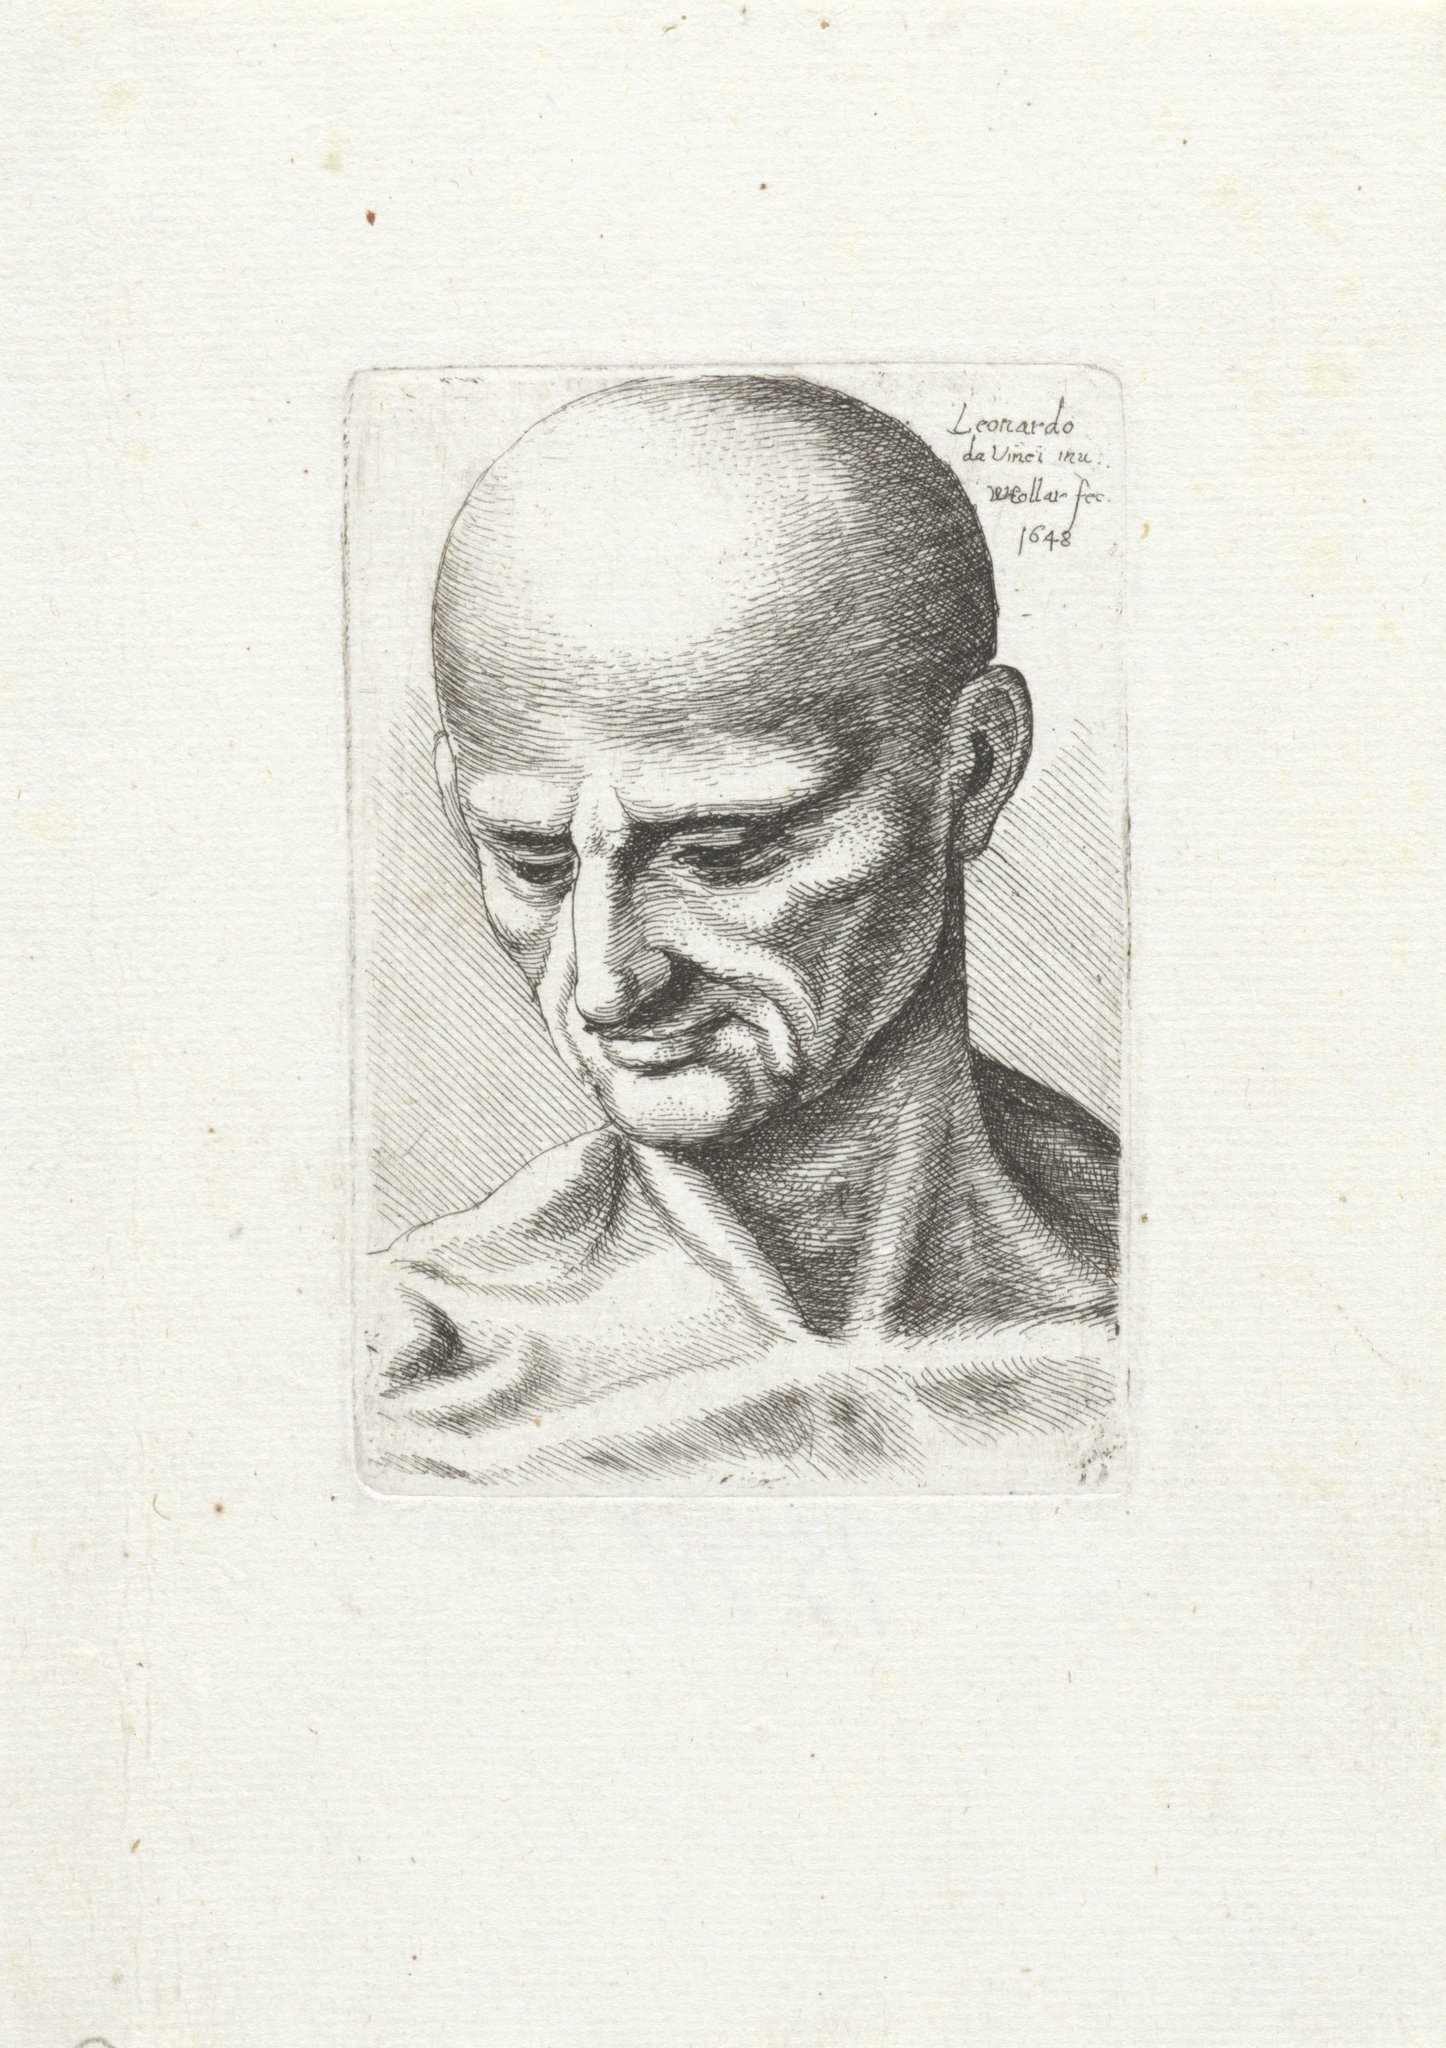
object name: print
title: Hoofd en nek van een pezige kale man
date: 1648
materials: paper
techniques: etching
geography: antwerp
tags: head (human), adult man, tendons, sinews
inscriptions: date